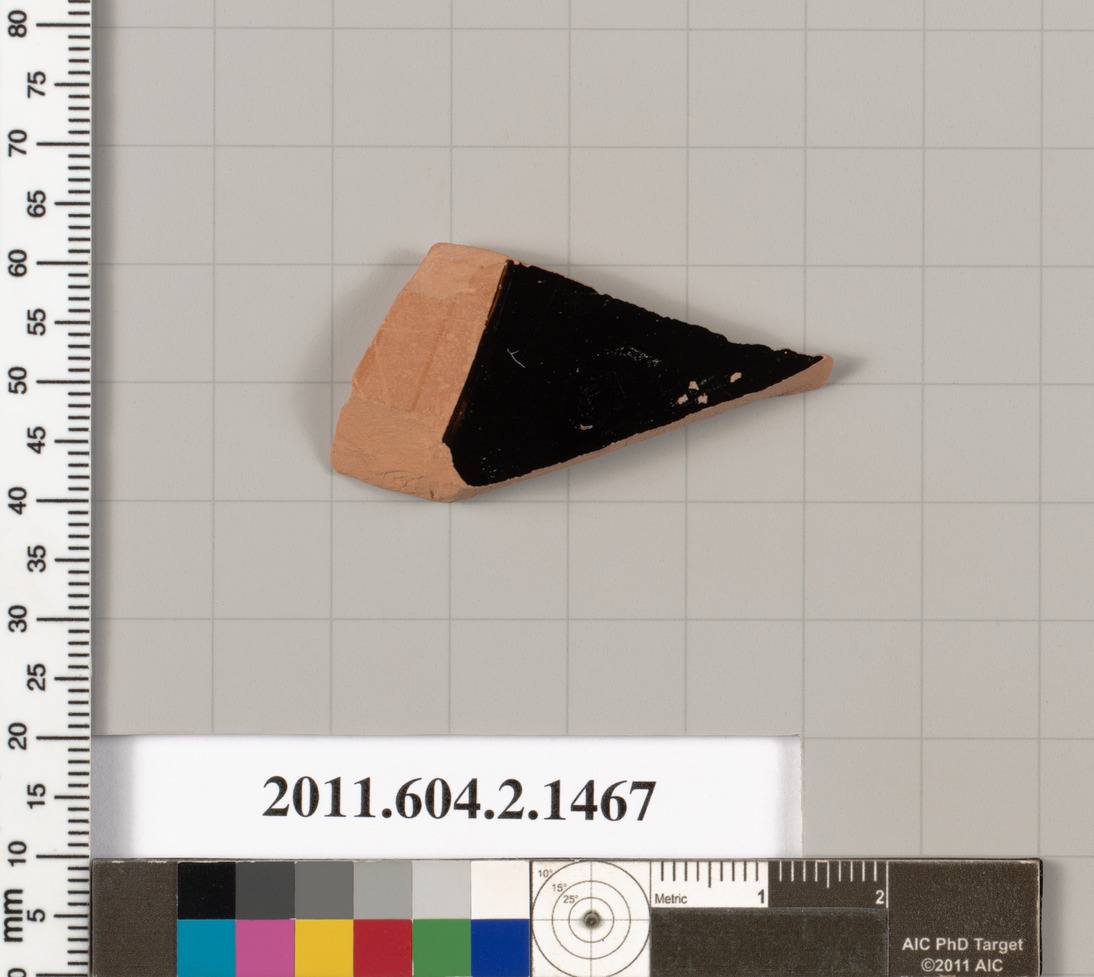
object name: skyphos fragment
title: Terracotta fragment of a skyphos (deep drinking cup)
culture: greek, attic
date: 475-425 BCE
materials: terracotta